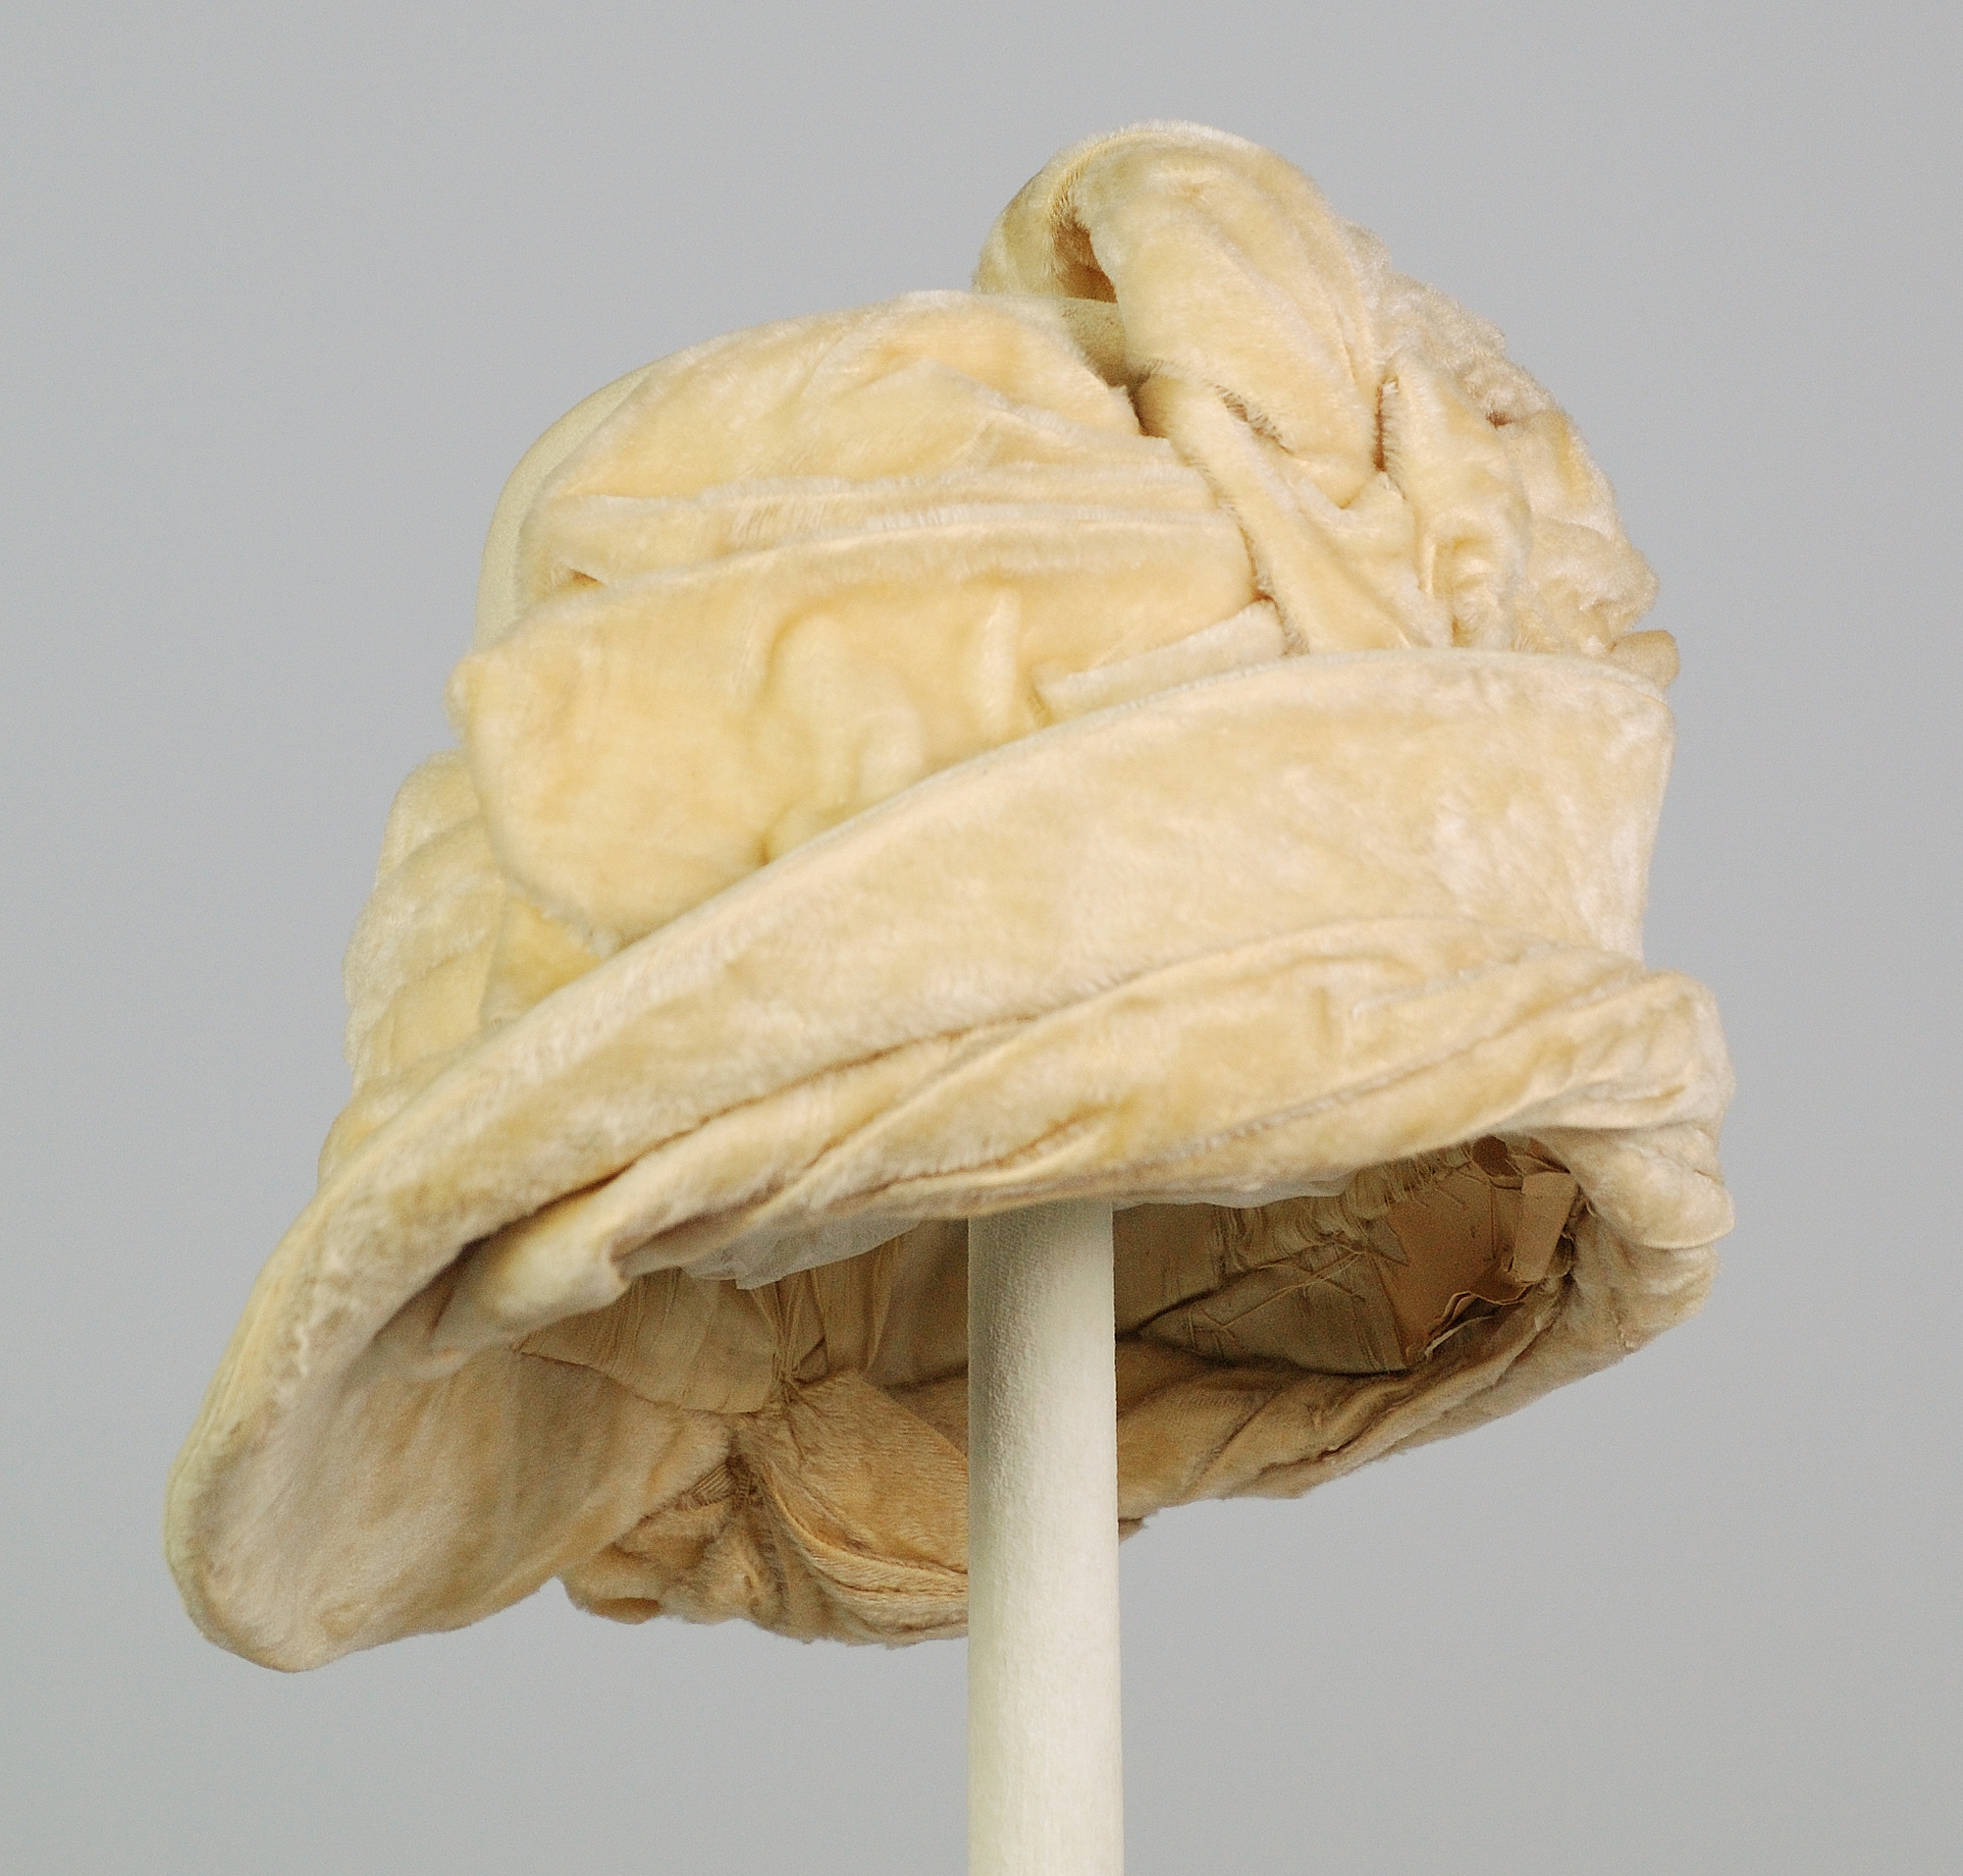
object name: wedding hat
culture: american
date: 1887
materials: silk, wool